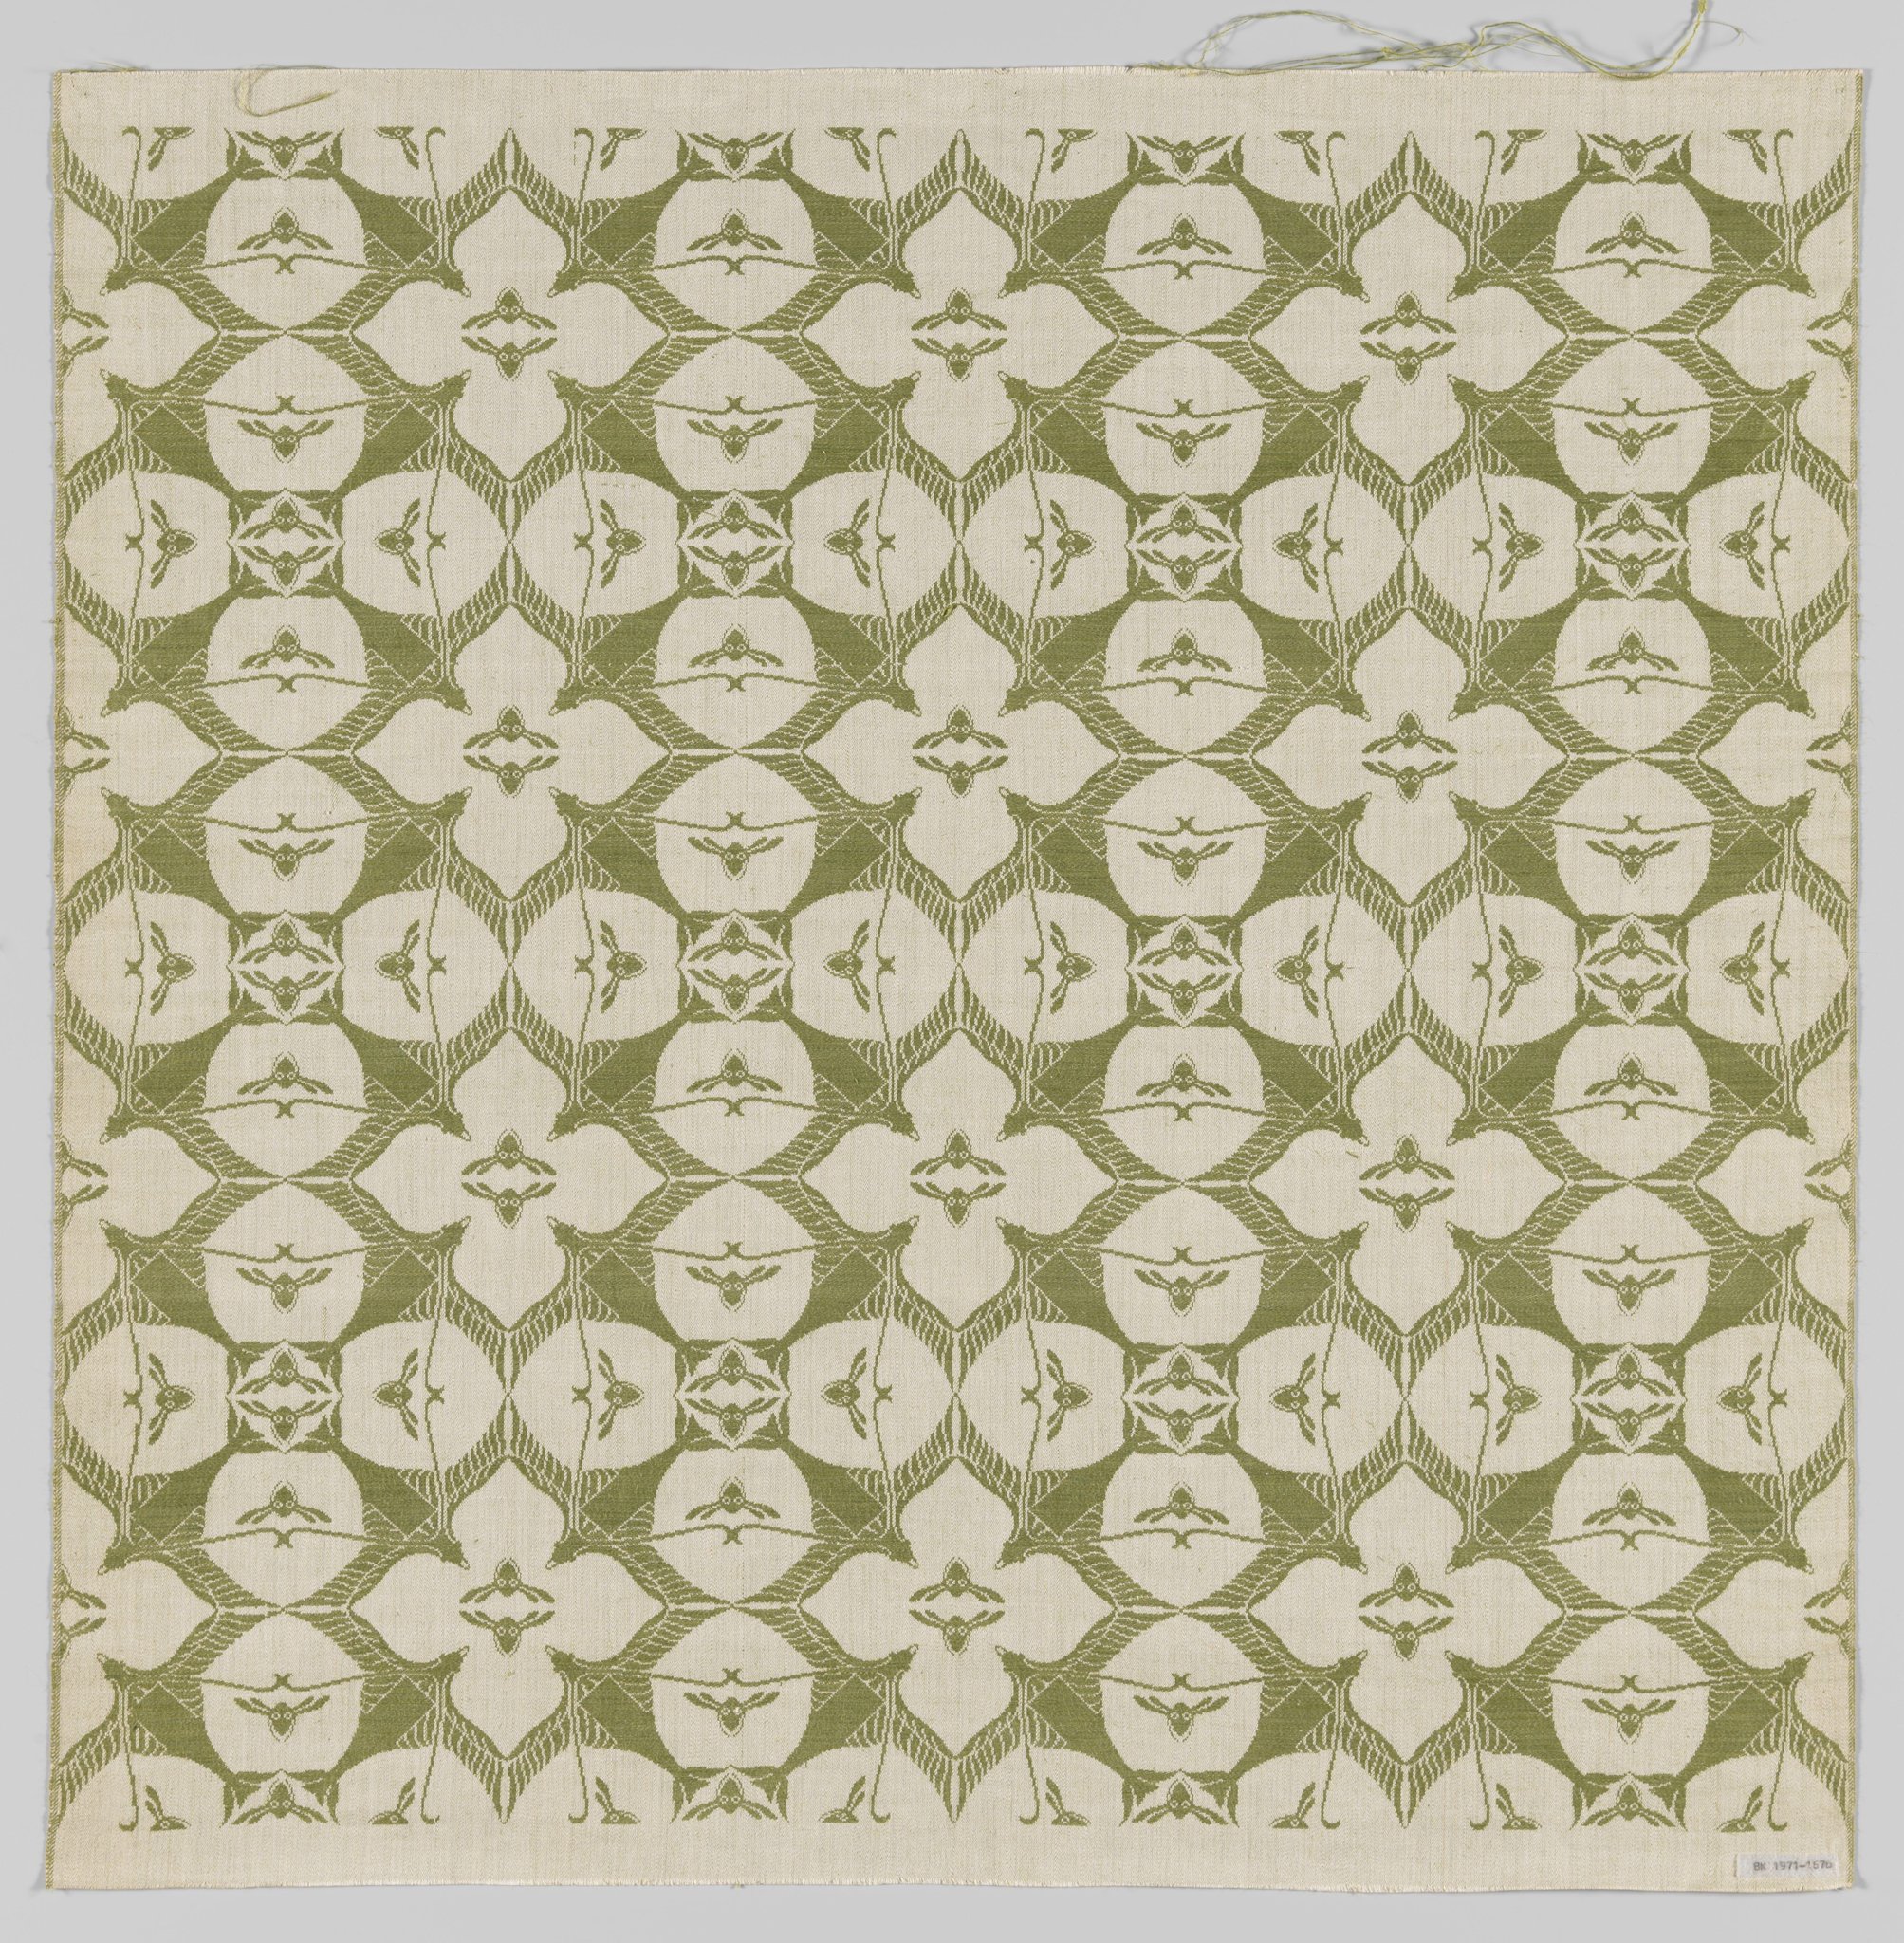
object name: upholstery fabric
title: Staal bespanningsstof van linnendamast met dessin van zwaluwen en bijen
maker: chris lebeau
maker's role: draughtsman, print maker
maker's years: 1878-1945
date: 1911-1915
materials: linen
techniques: damask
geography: eindhoven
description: Staal bespanningsstof van linnendamast met dessin van zwaluwen en bijen in naturel op een lichtgroene fond.